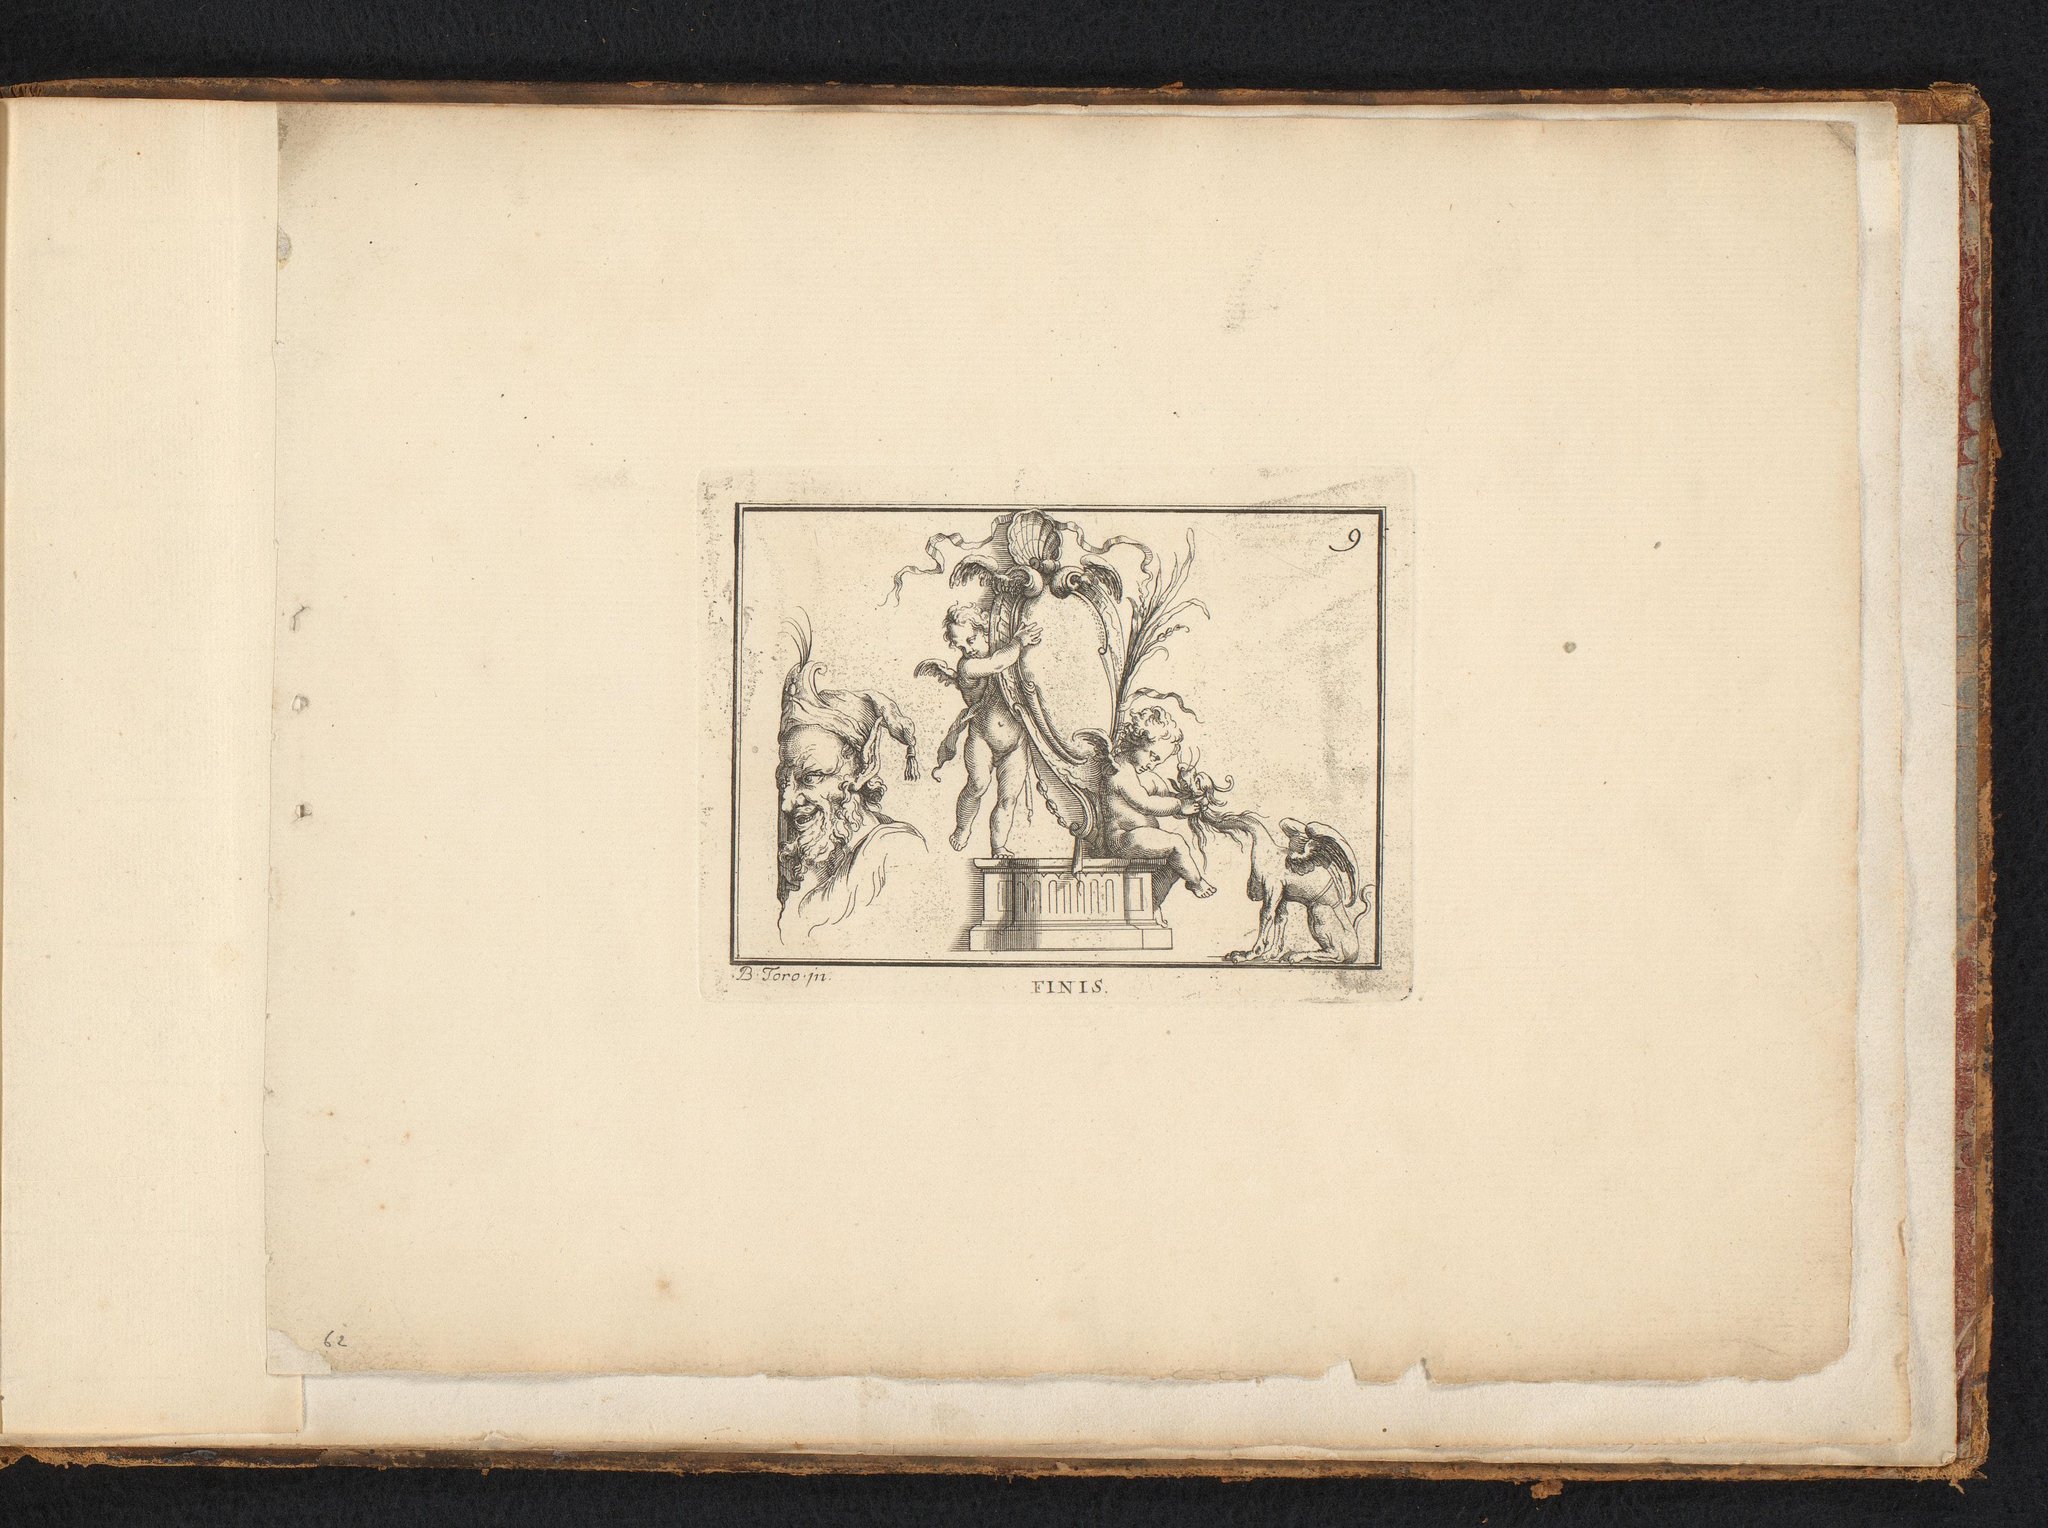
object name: print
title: Ontwerpen voor maskers en andere ornamenten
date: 1745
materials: paper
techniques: etching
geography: london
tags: fabulous animals (sometimes wrongly called 'grotesques'); 'mostri' (ripa), ornament ~ cartouche, mask, mascaron ~ ornament, cupids: 'amores', 'amoretti', 'putti'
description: Rechtsboven genummerd: 9. Prent maakt deel uit van een album.